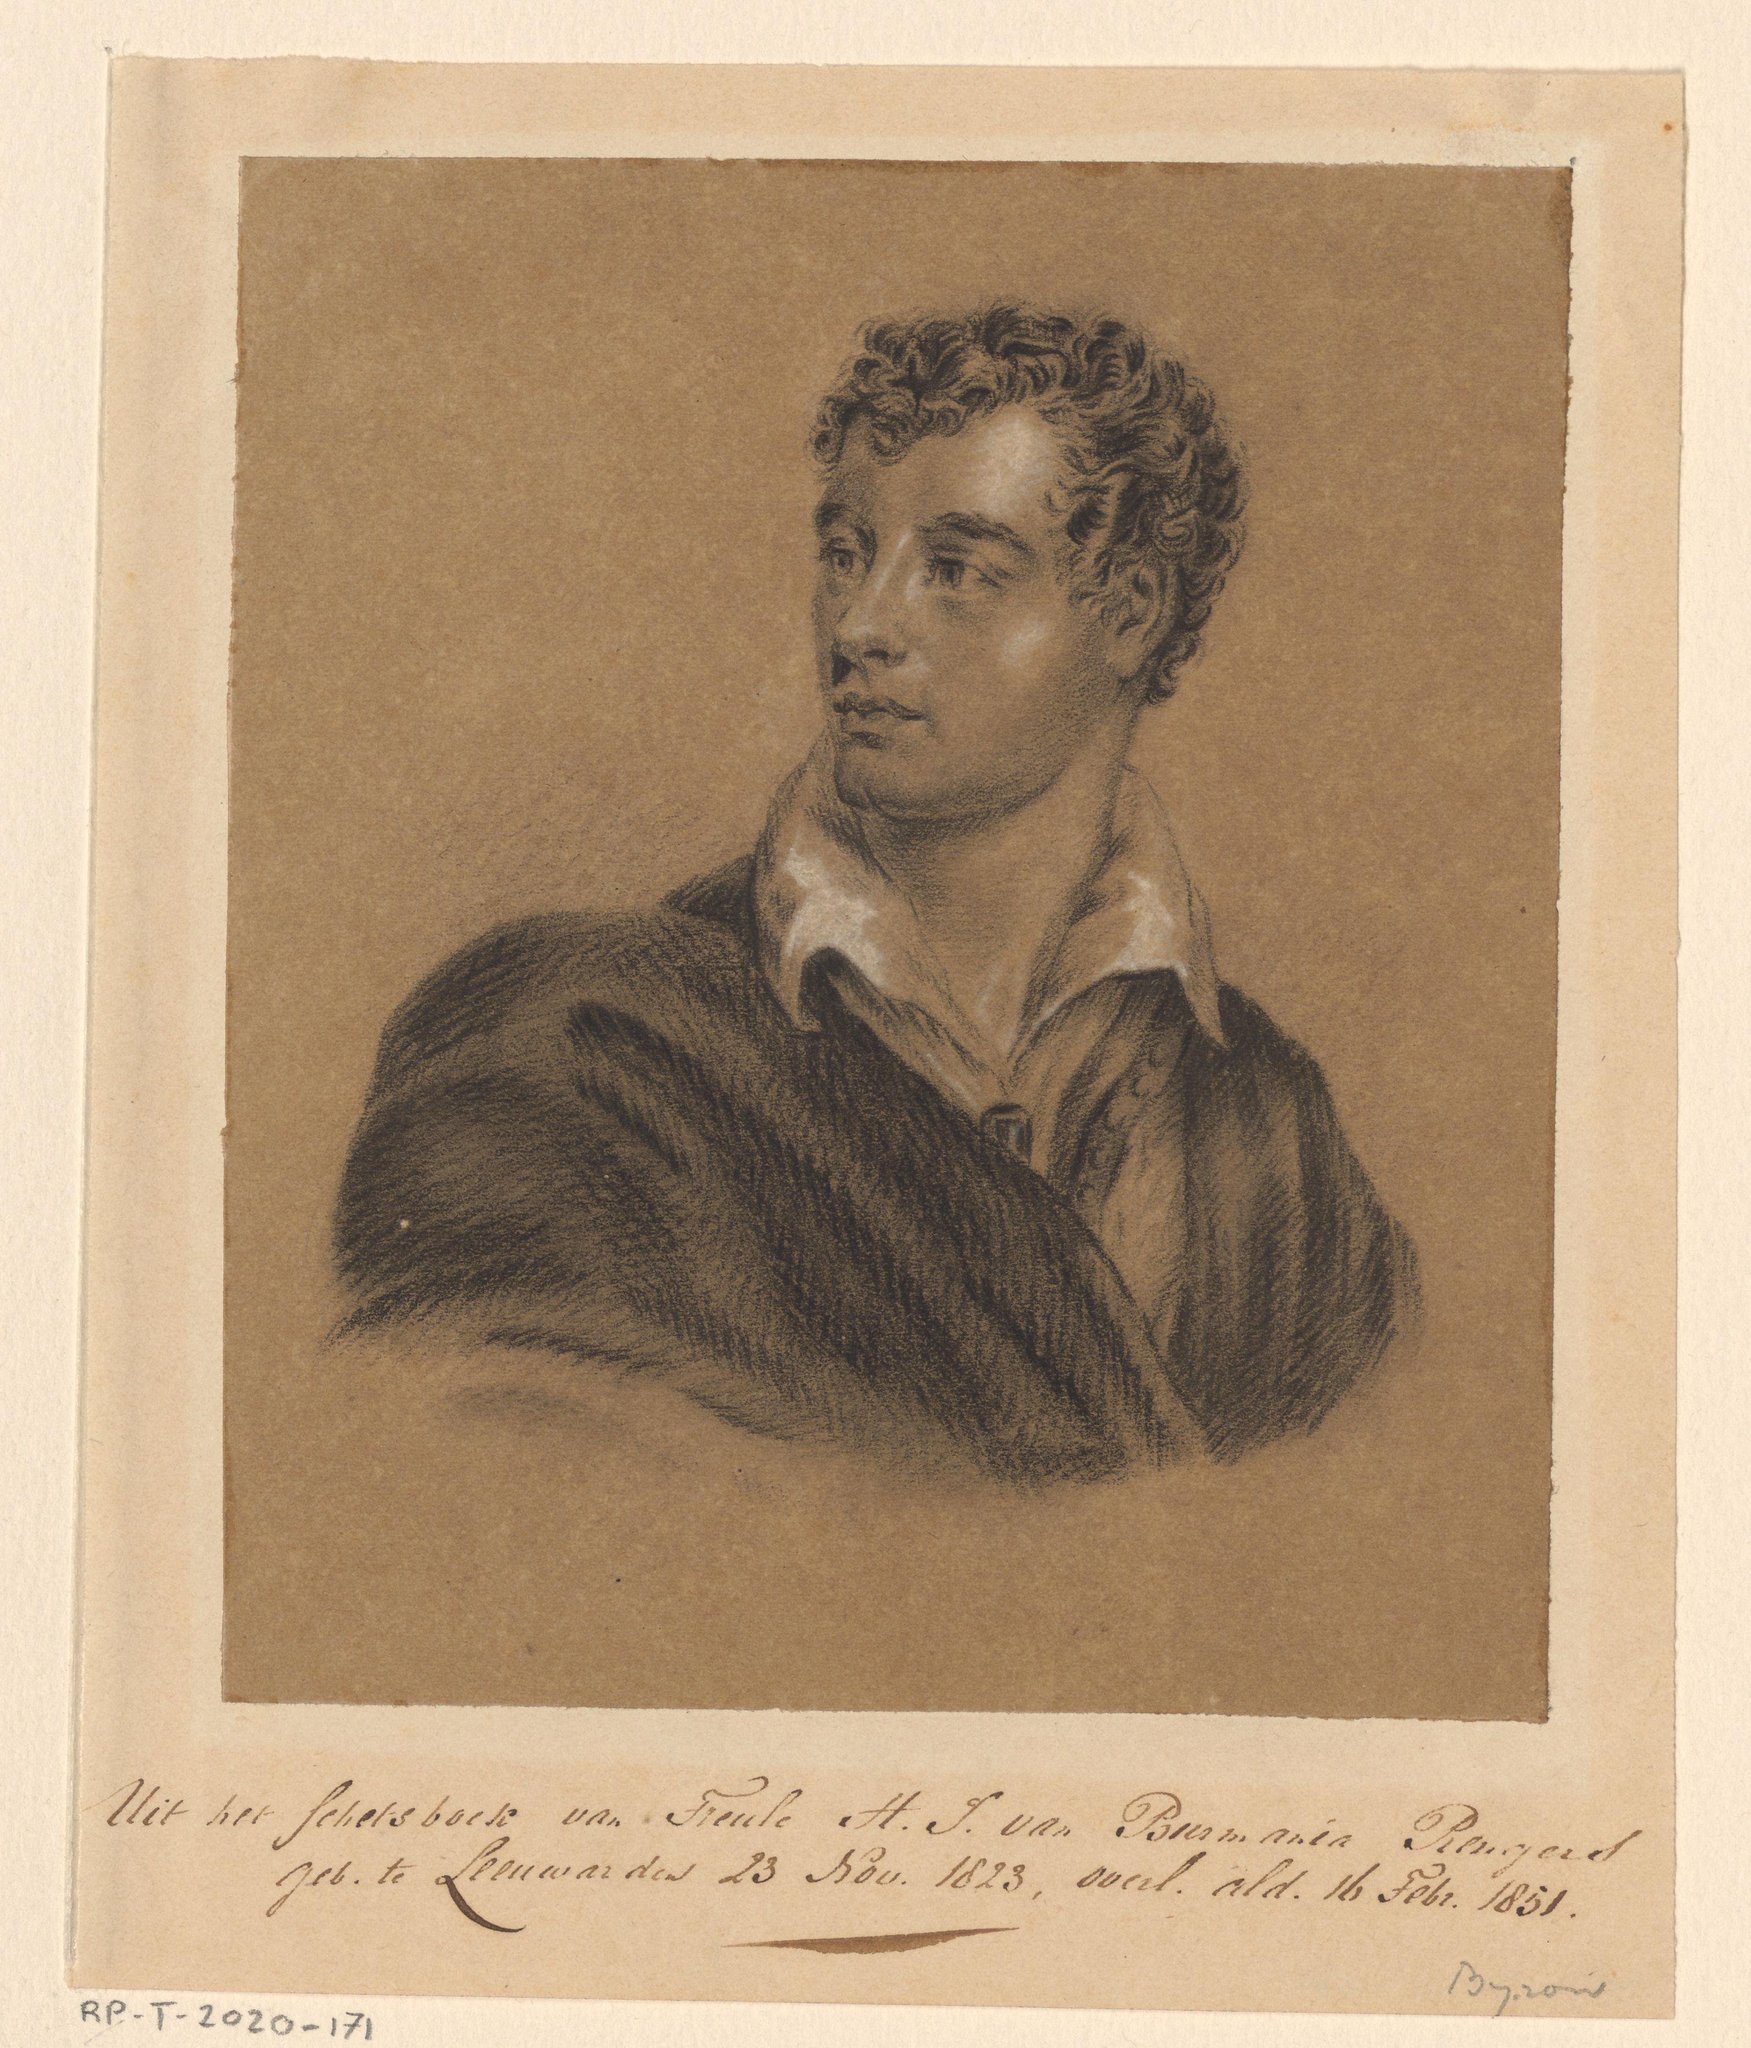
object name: drawing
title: Portret van Lord Byron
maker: henriëtte jacoba van burmania rengers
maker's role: draughtsman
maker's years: 1823-1851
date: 1833-1851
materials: chalk, paper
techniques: pasting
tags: lord byron, historical persons, writer, poet, author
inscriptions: inscription: ‘Uit het schetsboek van Freule H.J. van Burmania Rengers/ geb. te Leeuwarden 23 Nov. 1823, overl. ald. 16 Febr. 1851.’